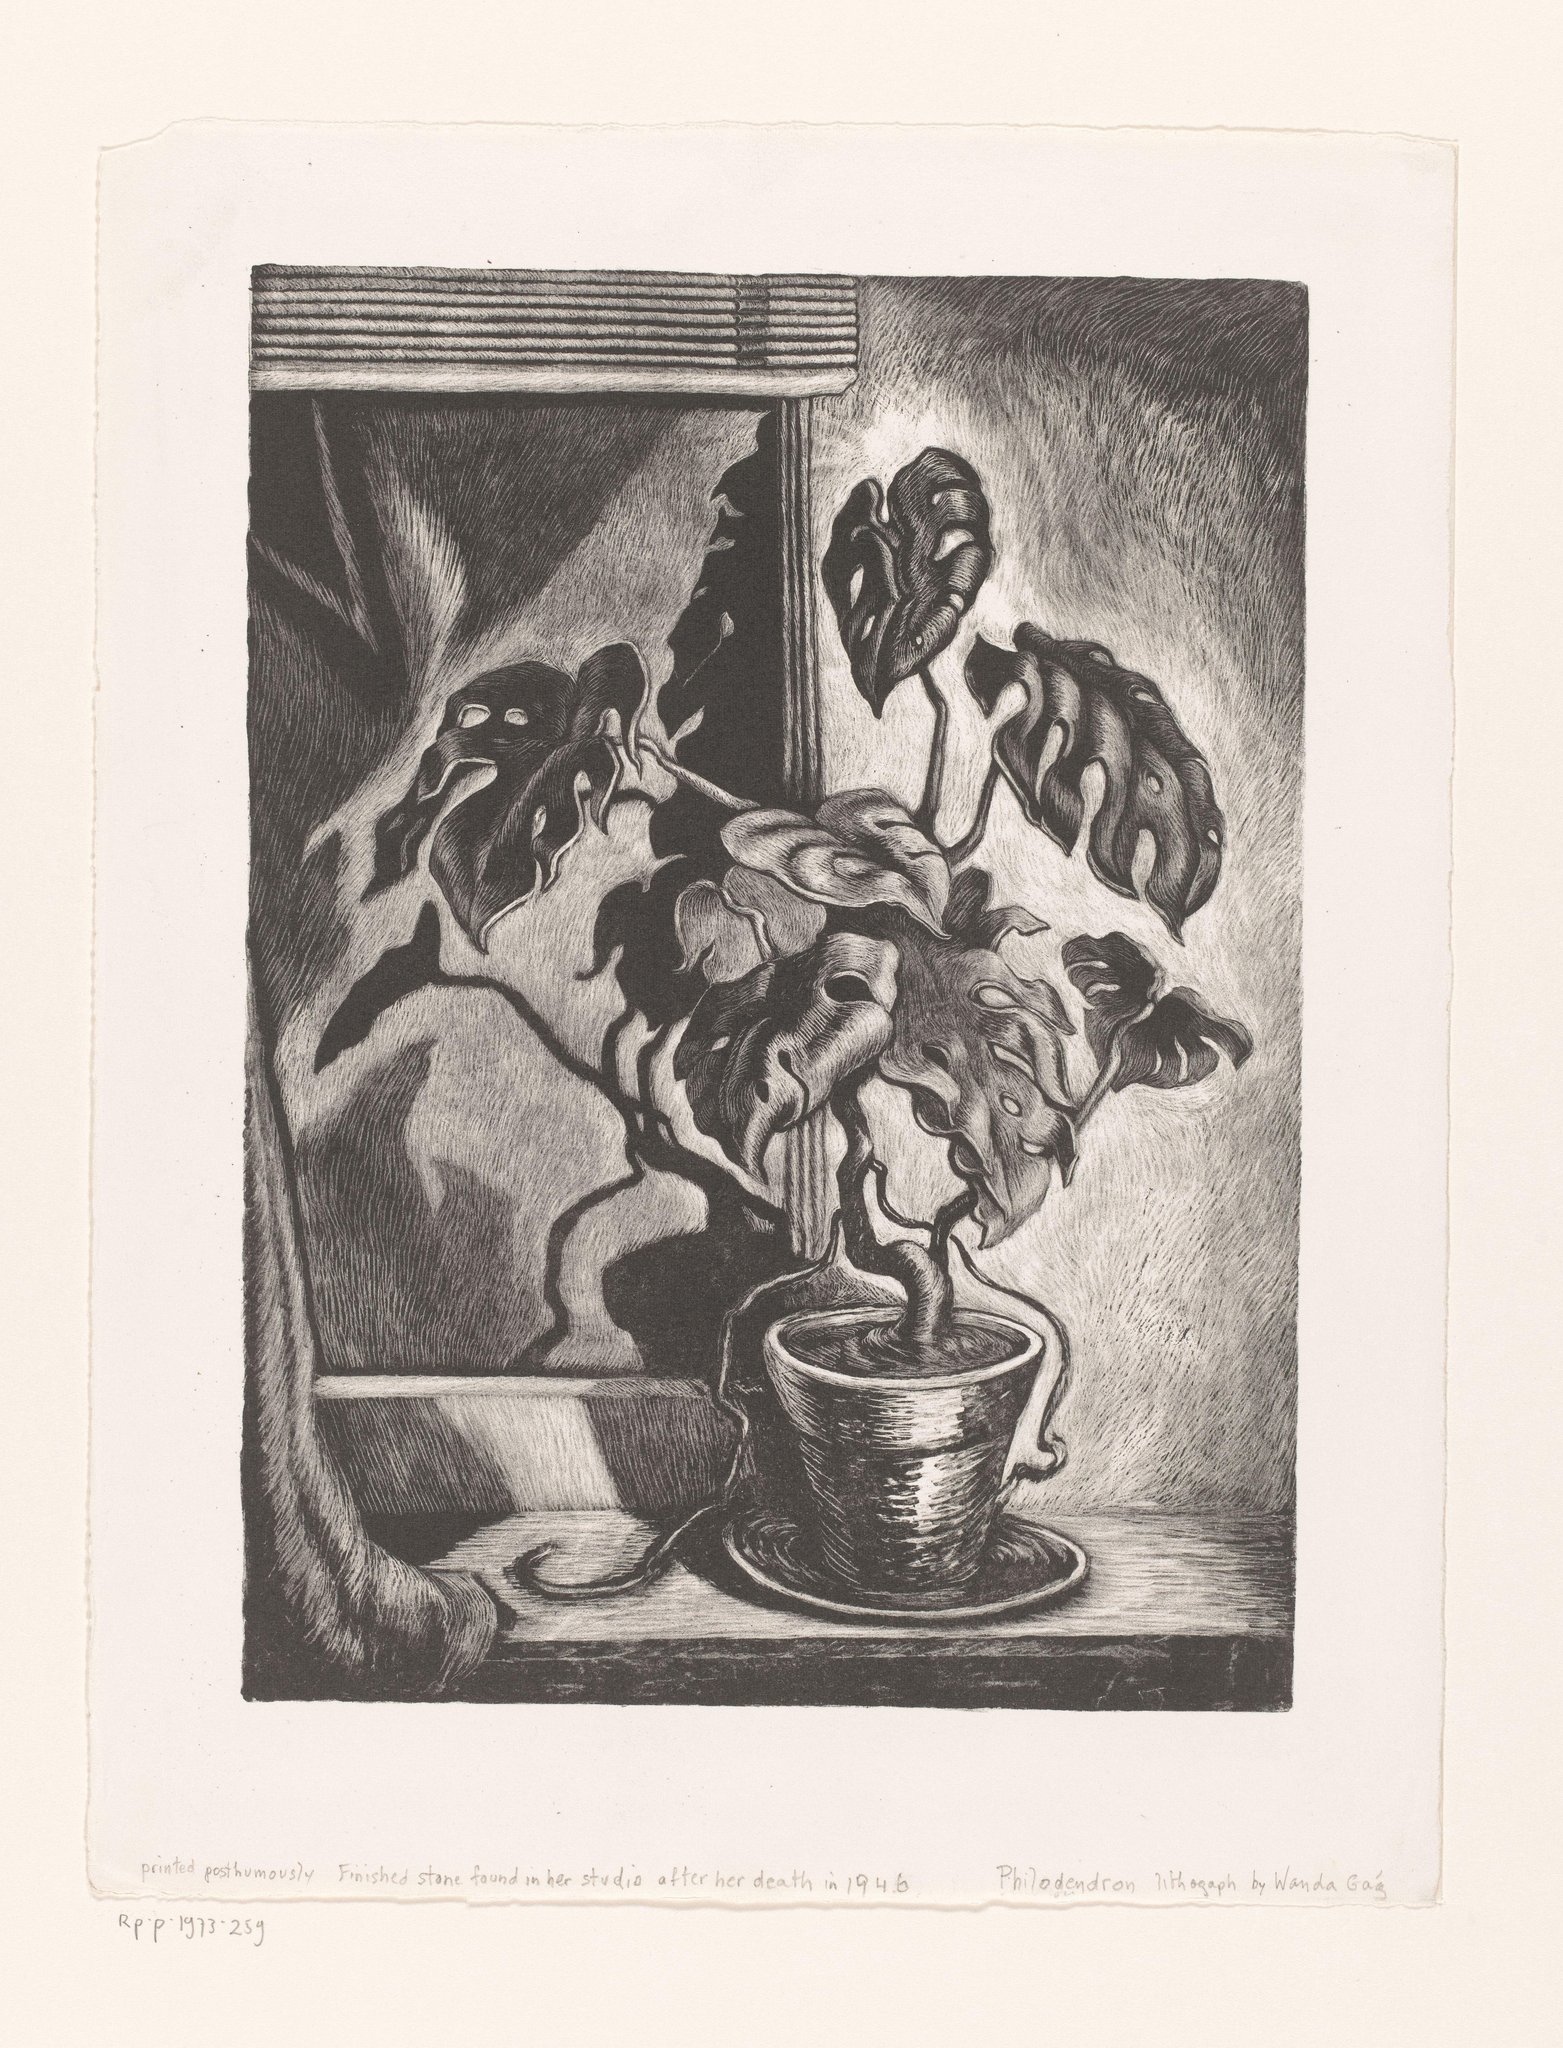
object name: print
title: Philodendron in raamkozijn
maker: wanda gág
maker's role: print maker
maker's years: 1893-1946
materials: paper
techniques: lithograph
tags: closed window, potted plants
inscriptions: collector's mark: Lugt 2228, annotation: ‘Printed posthumously Finished stone found in her studio after her death in 1946’